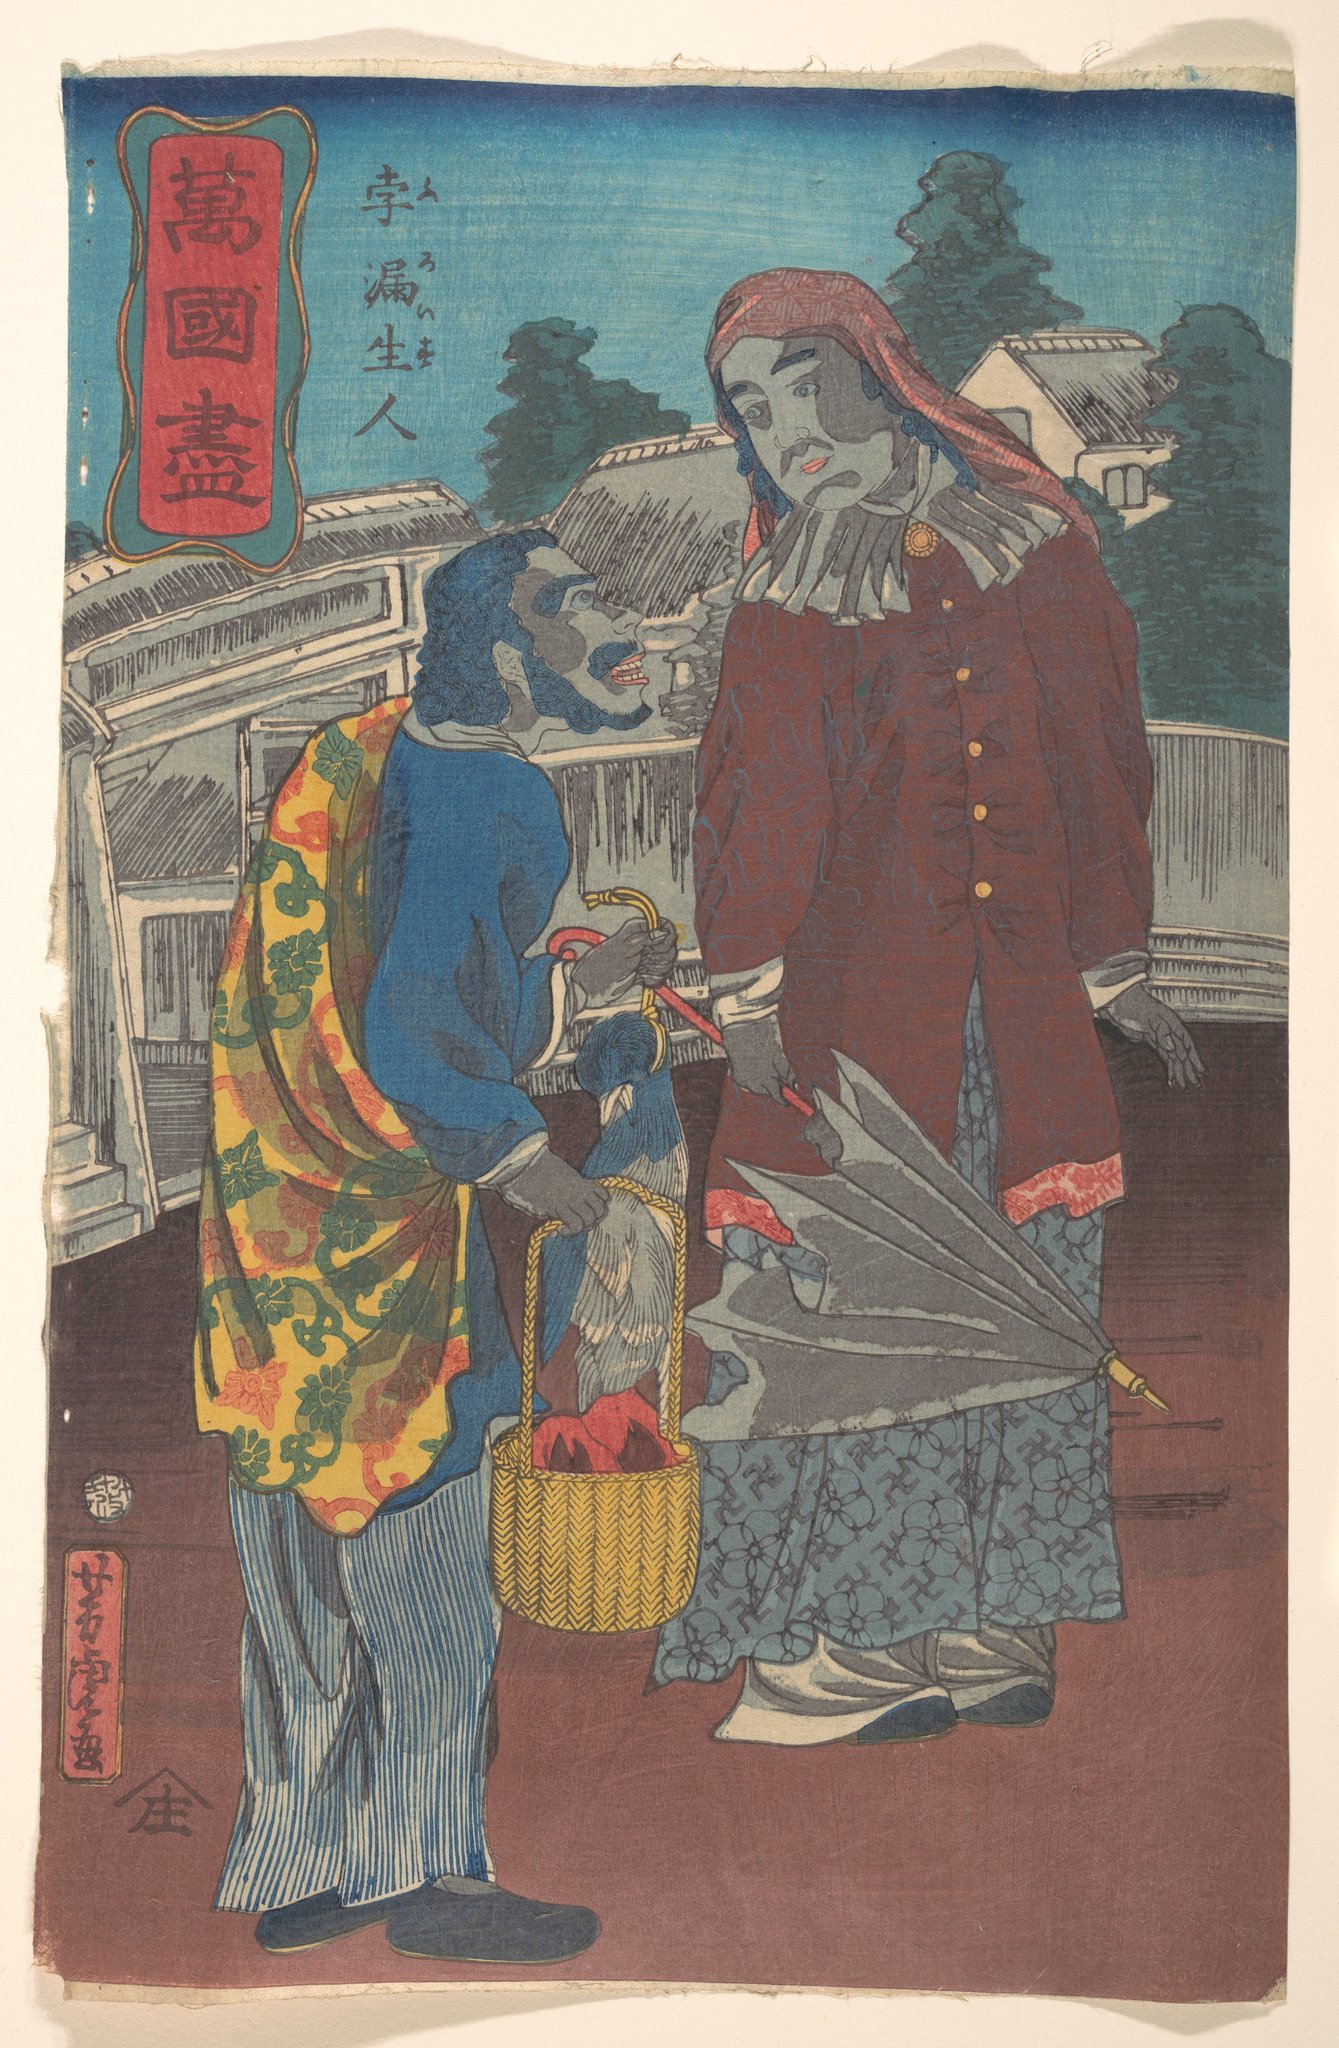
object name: print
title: A Prussian Couple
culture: japanese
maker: utagawa yoshitora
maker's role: artist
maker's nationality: japanese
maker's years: 1845-1880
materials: ink, paper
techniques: woodblock print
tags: birds,men